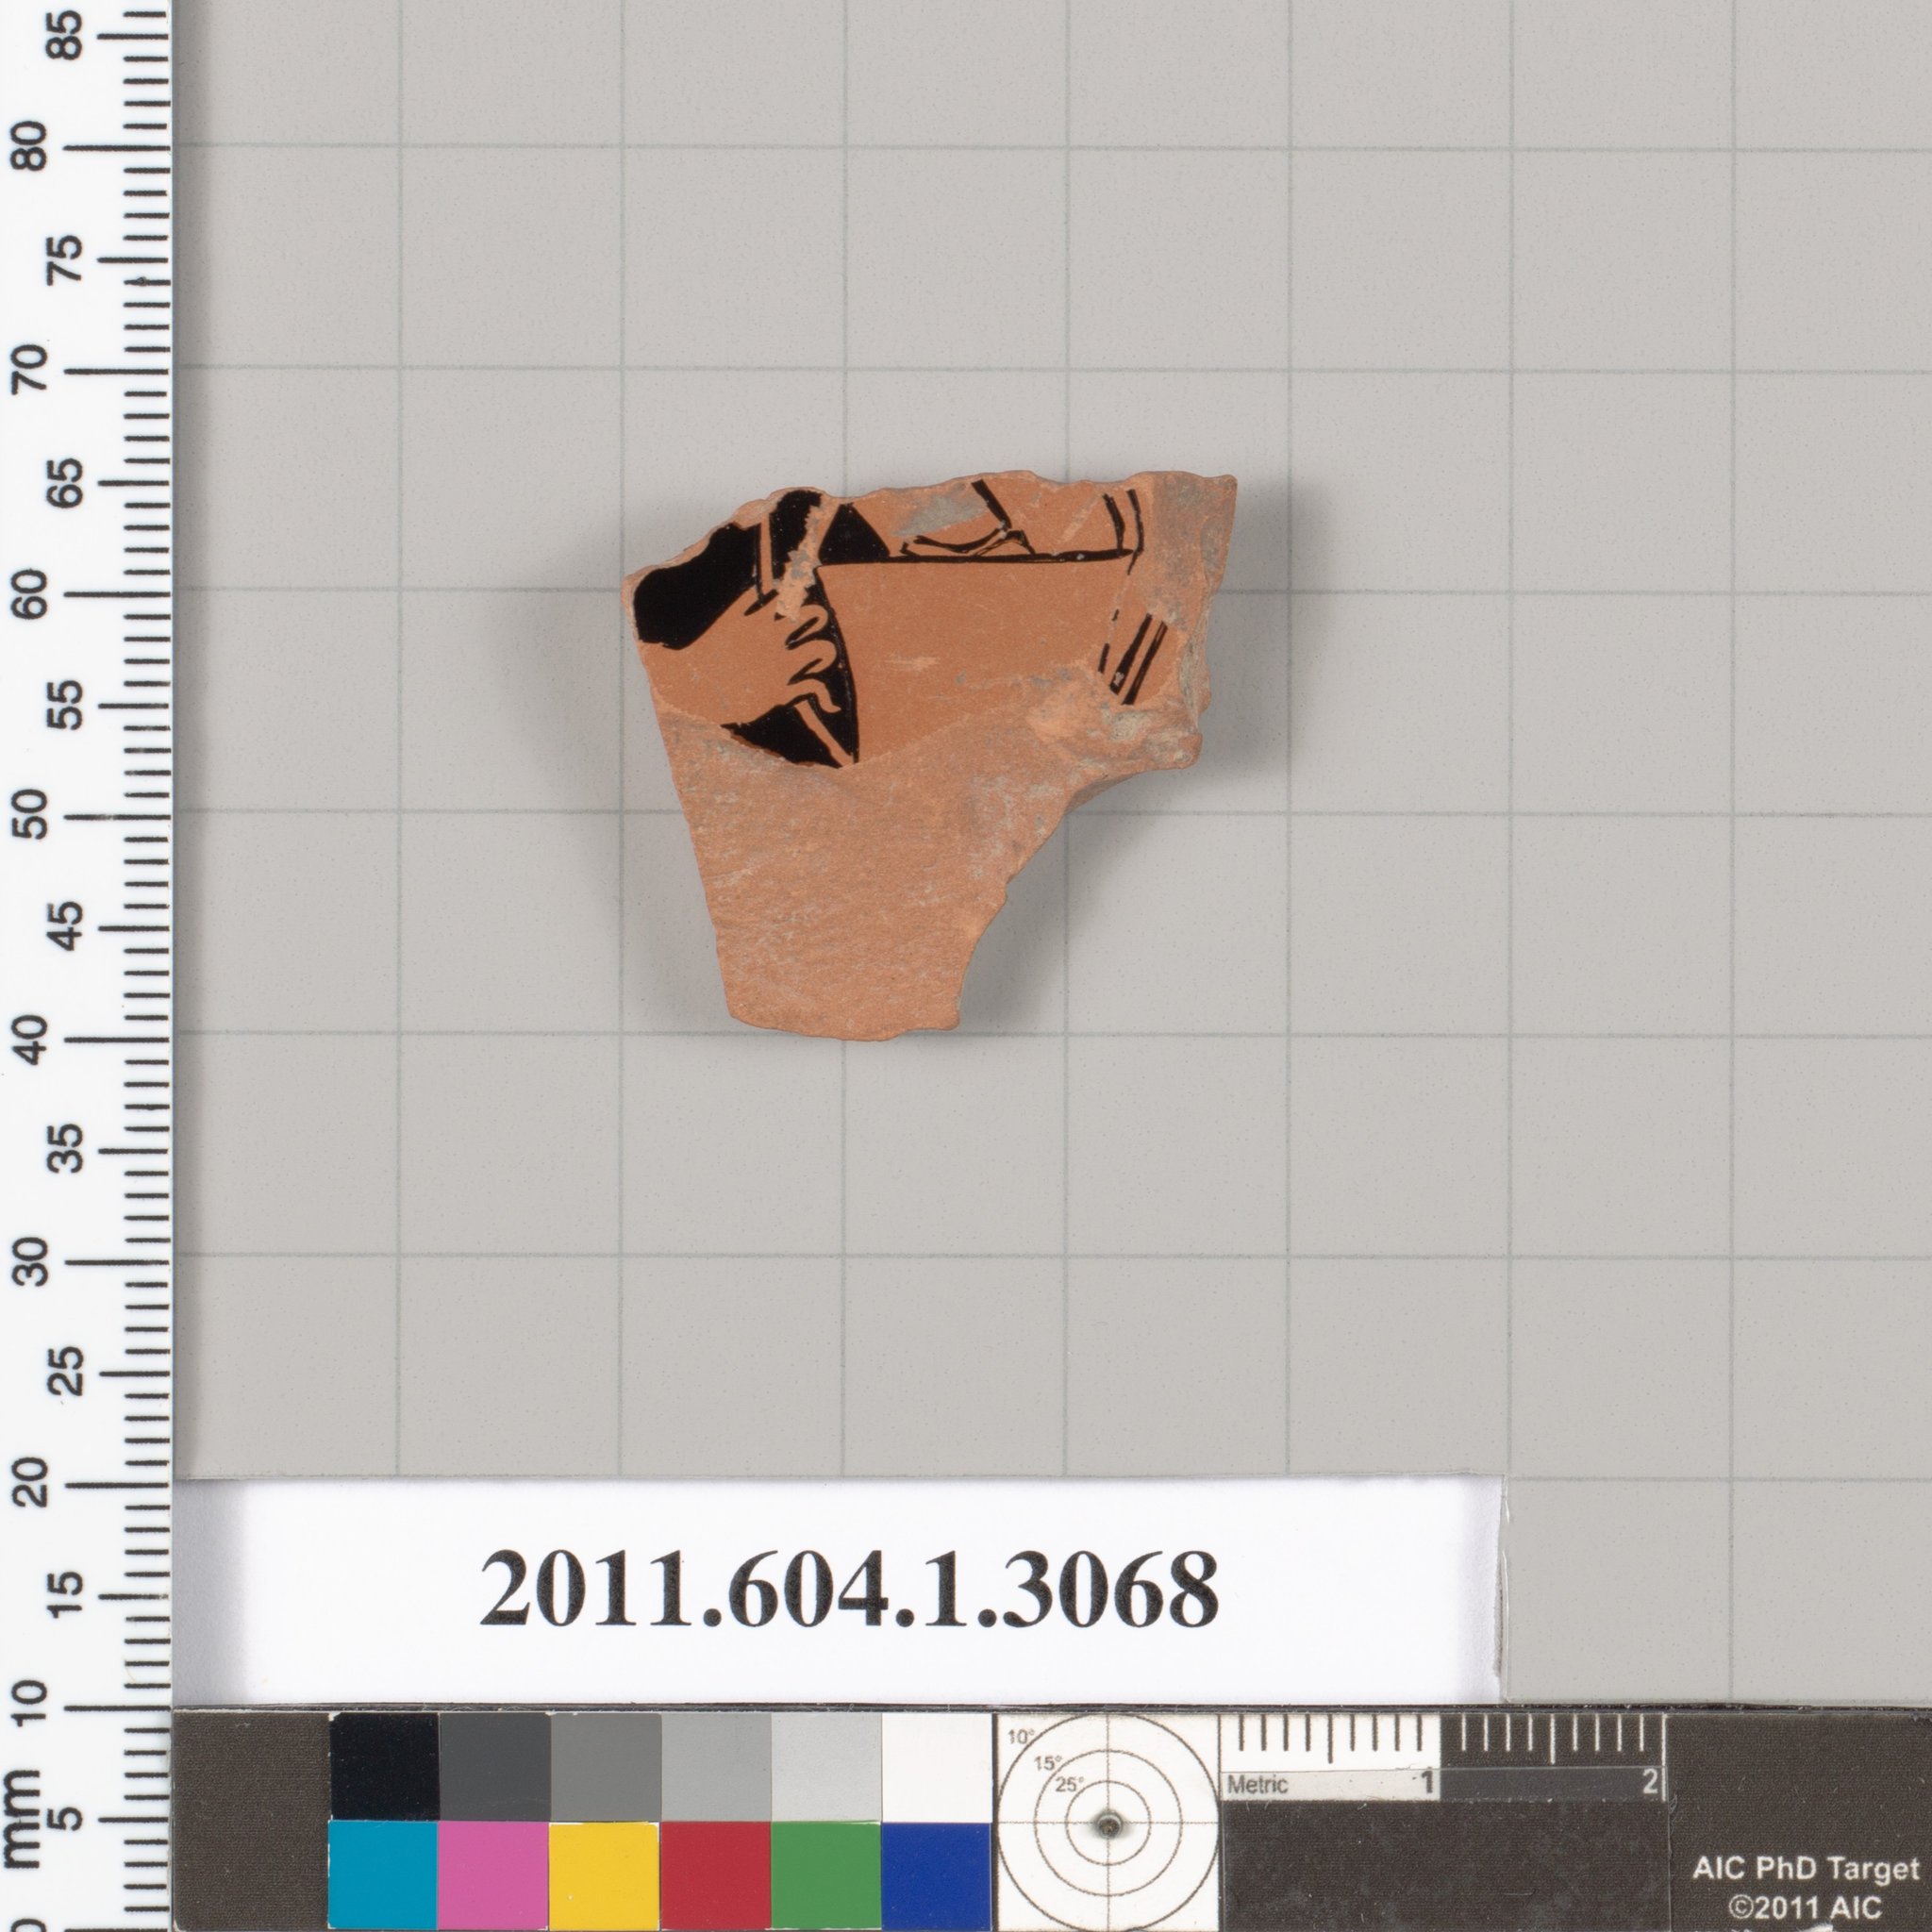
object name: kylix fragment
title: Terracotta fragment of a kylix (drinking cup)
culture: greek, attic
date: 490-480 BCE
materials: terracotta